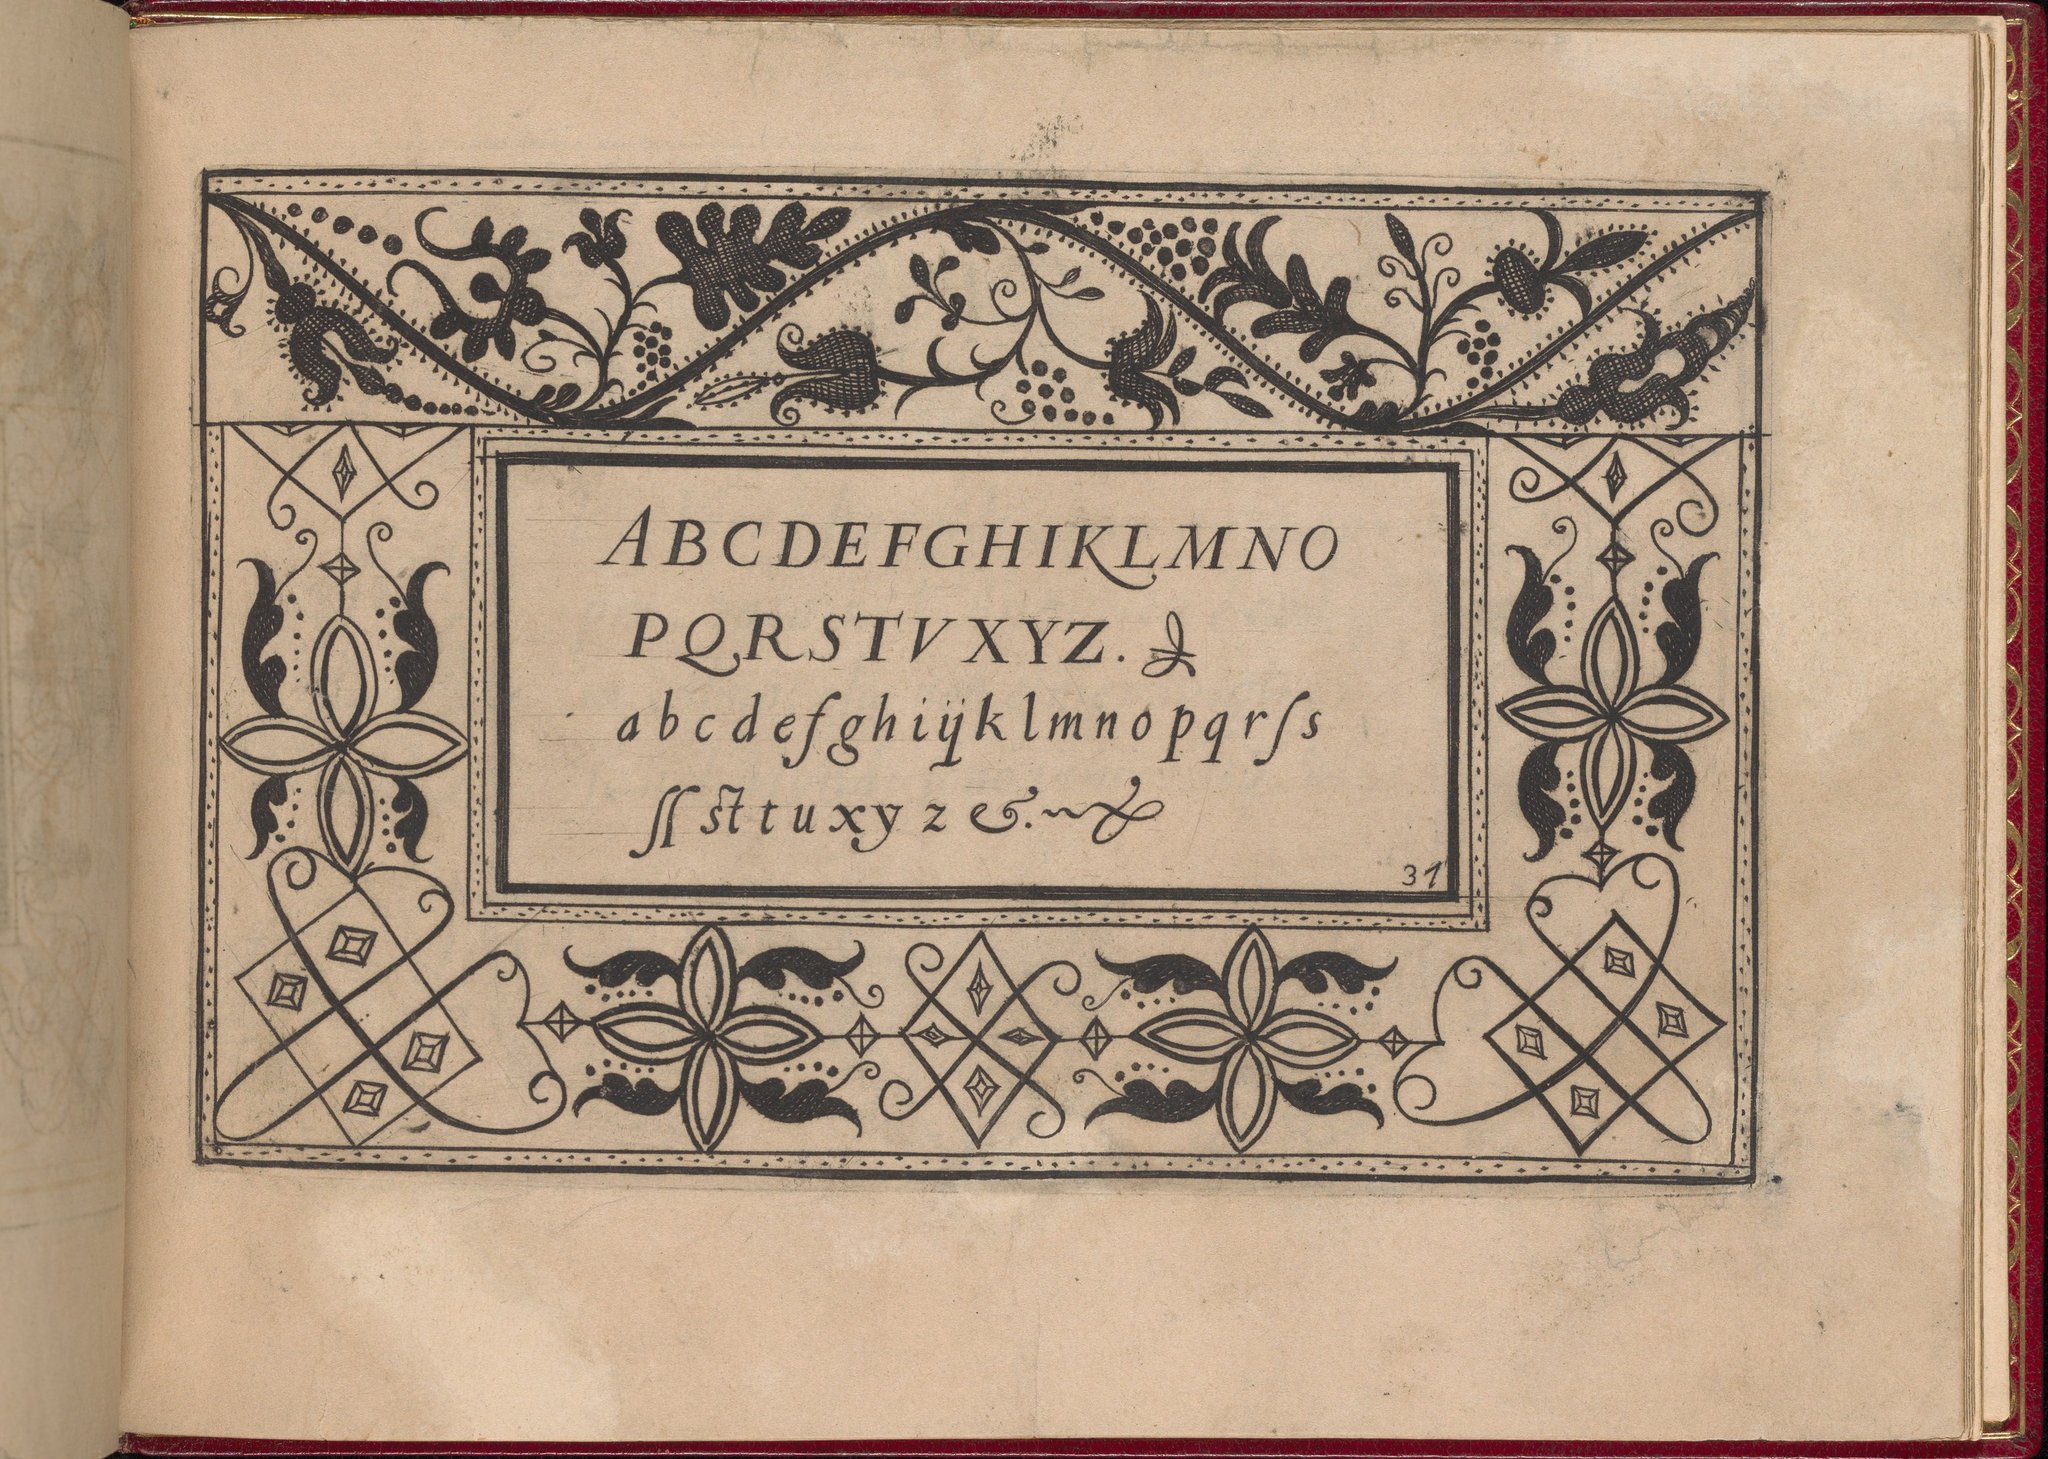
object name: book print ornament architecture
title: Ghirlanda: Di sei vaghi fiori scielti da piu famosi Giardini d'Italia, page 45 (recto)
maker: pietro paulo tozzi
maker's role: designer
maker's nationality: italian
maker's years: 1593-1628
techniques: drawing, etching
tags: flowers